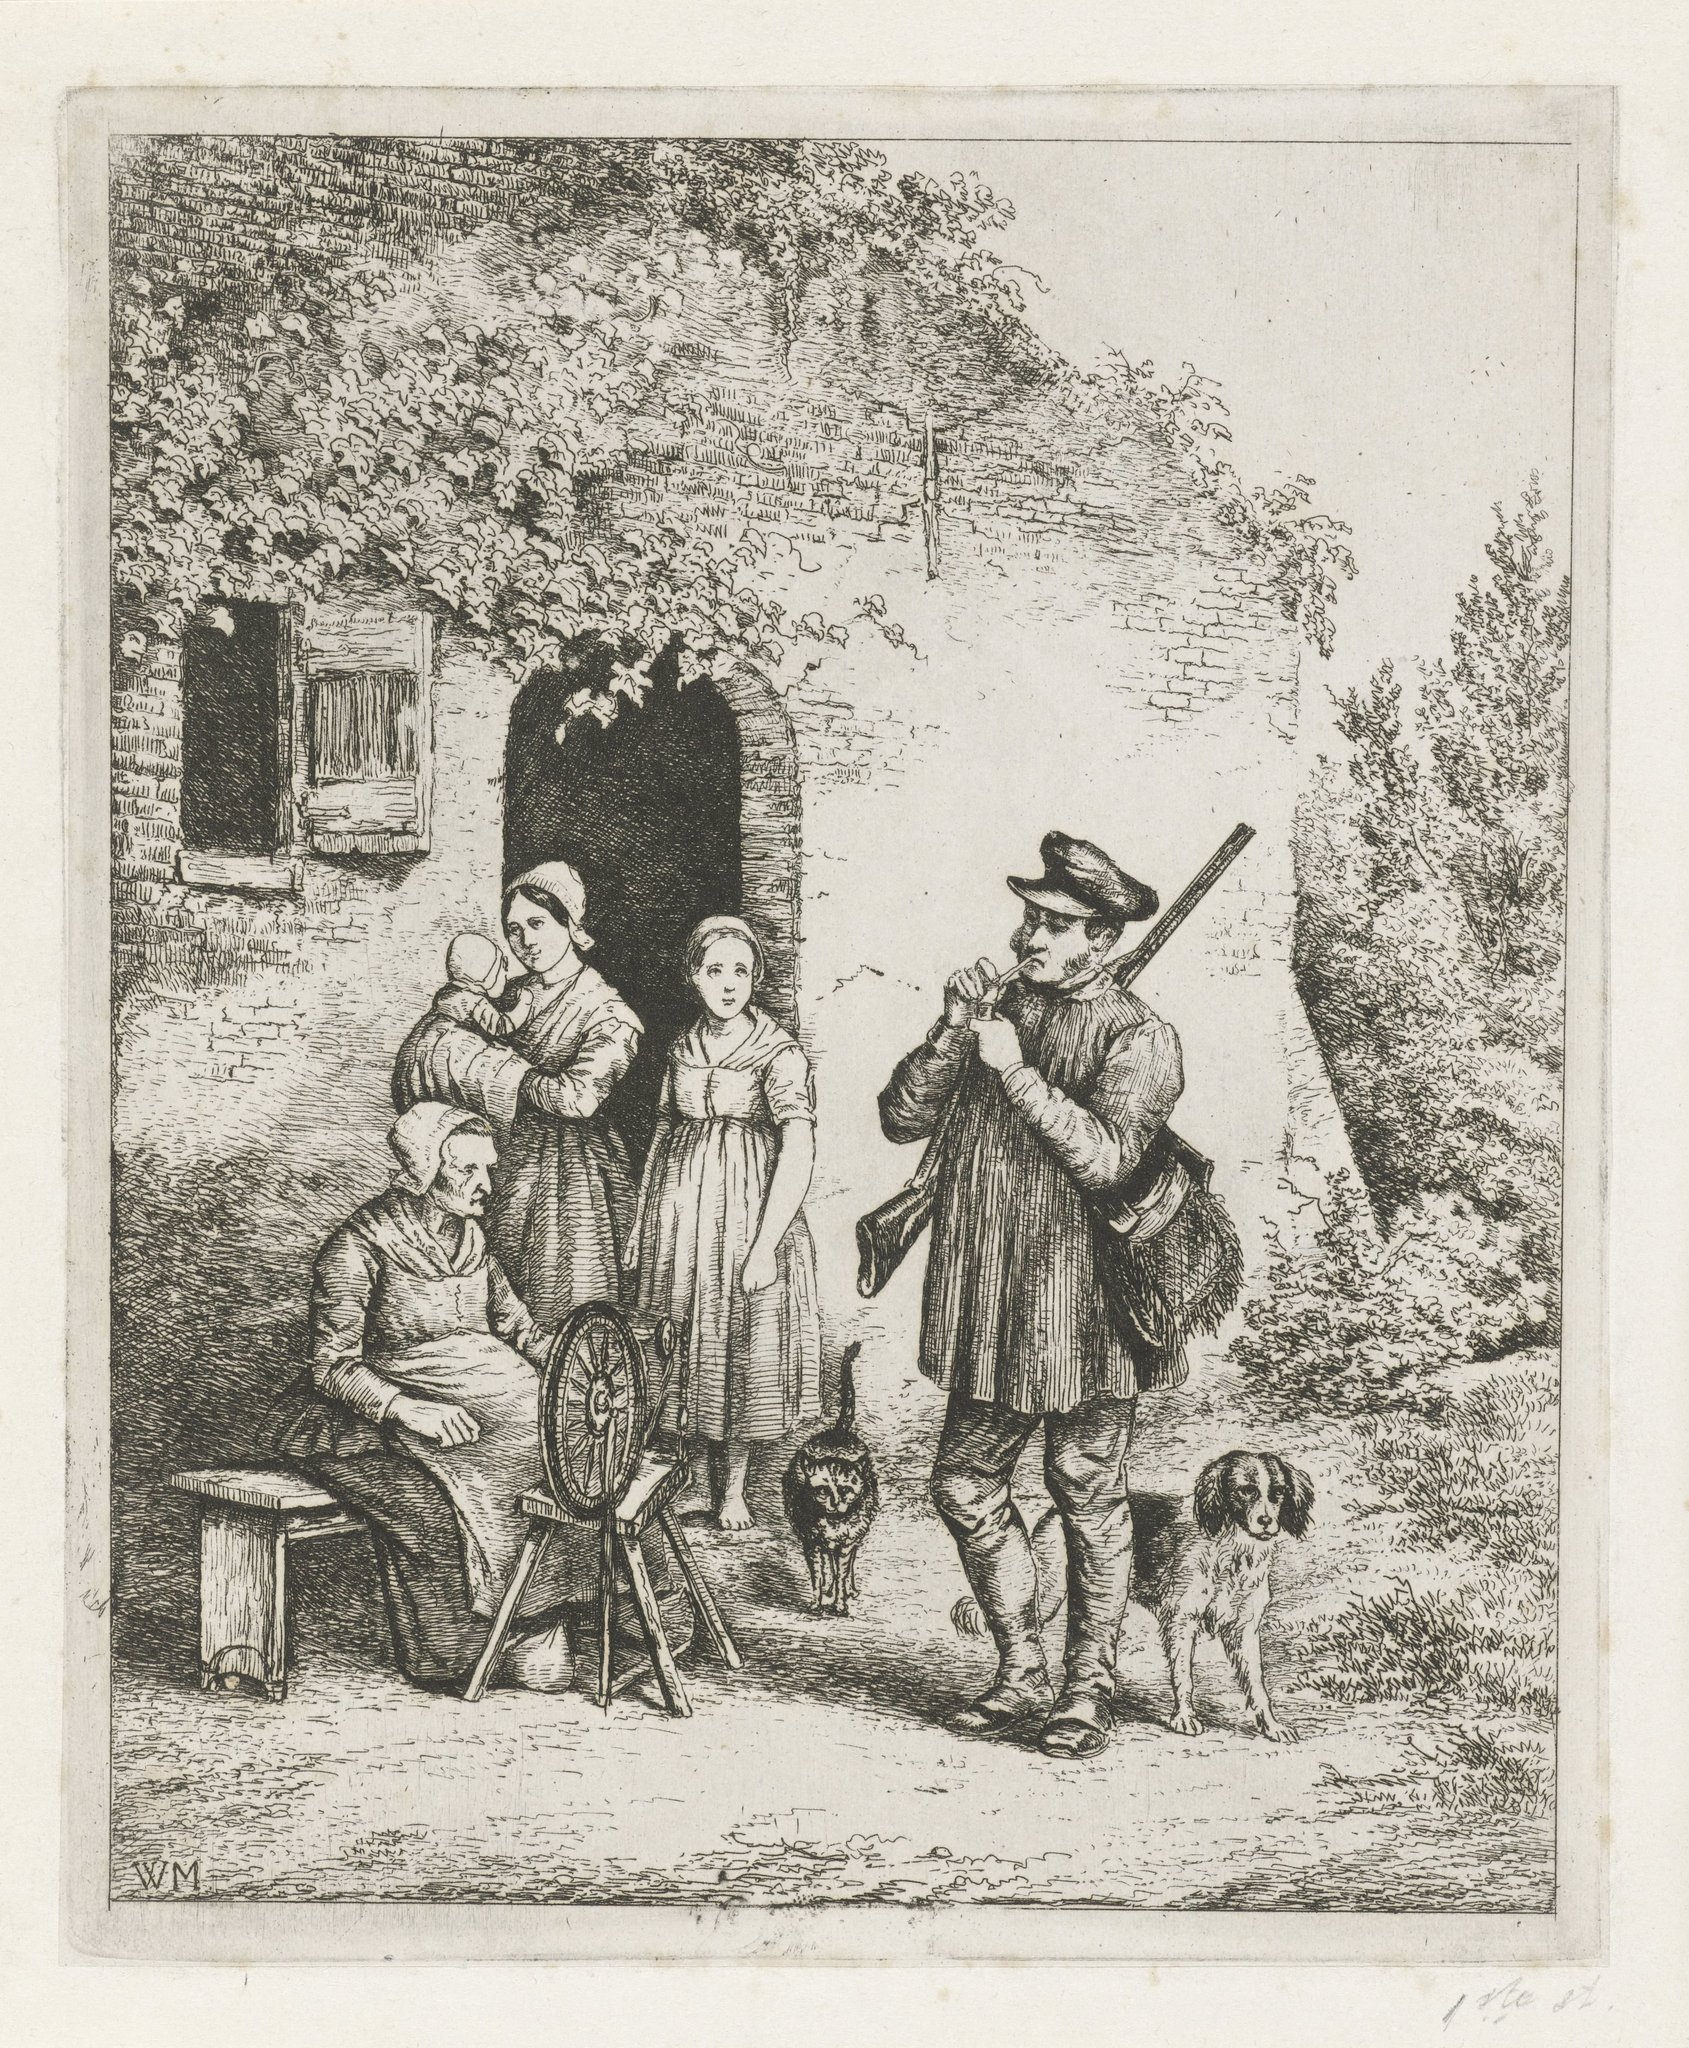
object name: print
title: Gezelschap voor de deur van een woning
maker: christiaan wilhelmus moorrees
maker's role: draughtsman, print maker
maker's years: 1801-1867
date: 1811-1867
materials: paper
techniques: etching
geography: netherlands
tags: open door, pipe ~ tobacco, spinning-wheel, mother and baby or young child, dog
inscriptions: collector's mark: Lugt 2228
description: Voor de deuropening van een woning staan een vrouw met een baby op de arm en een meisje. Op een bankje zit een oude vrouw achter een spinnewiel. Een man met een geweer aan de schouder gaat voorbij en steekt zijn pijp aan.